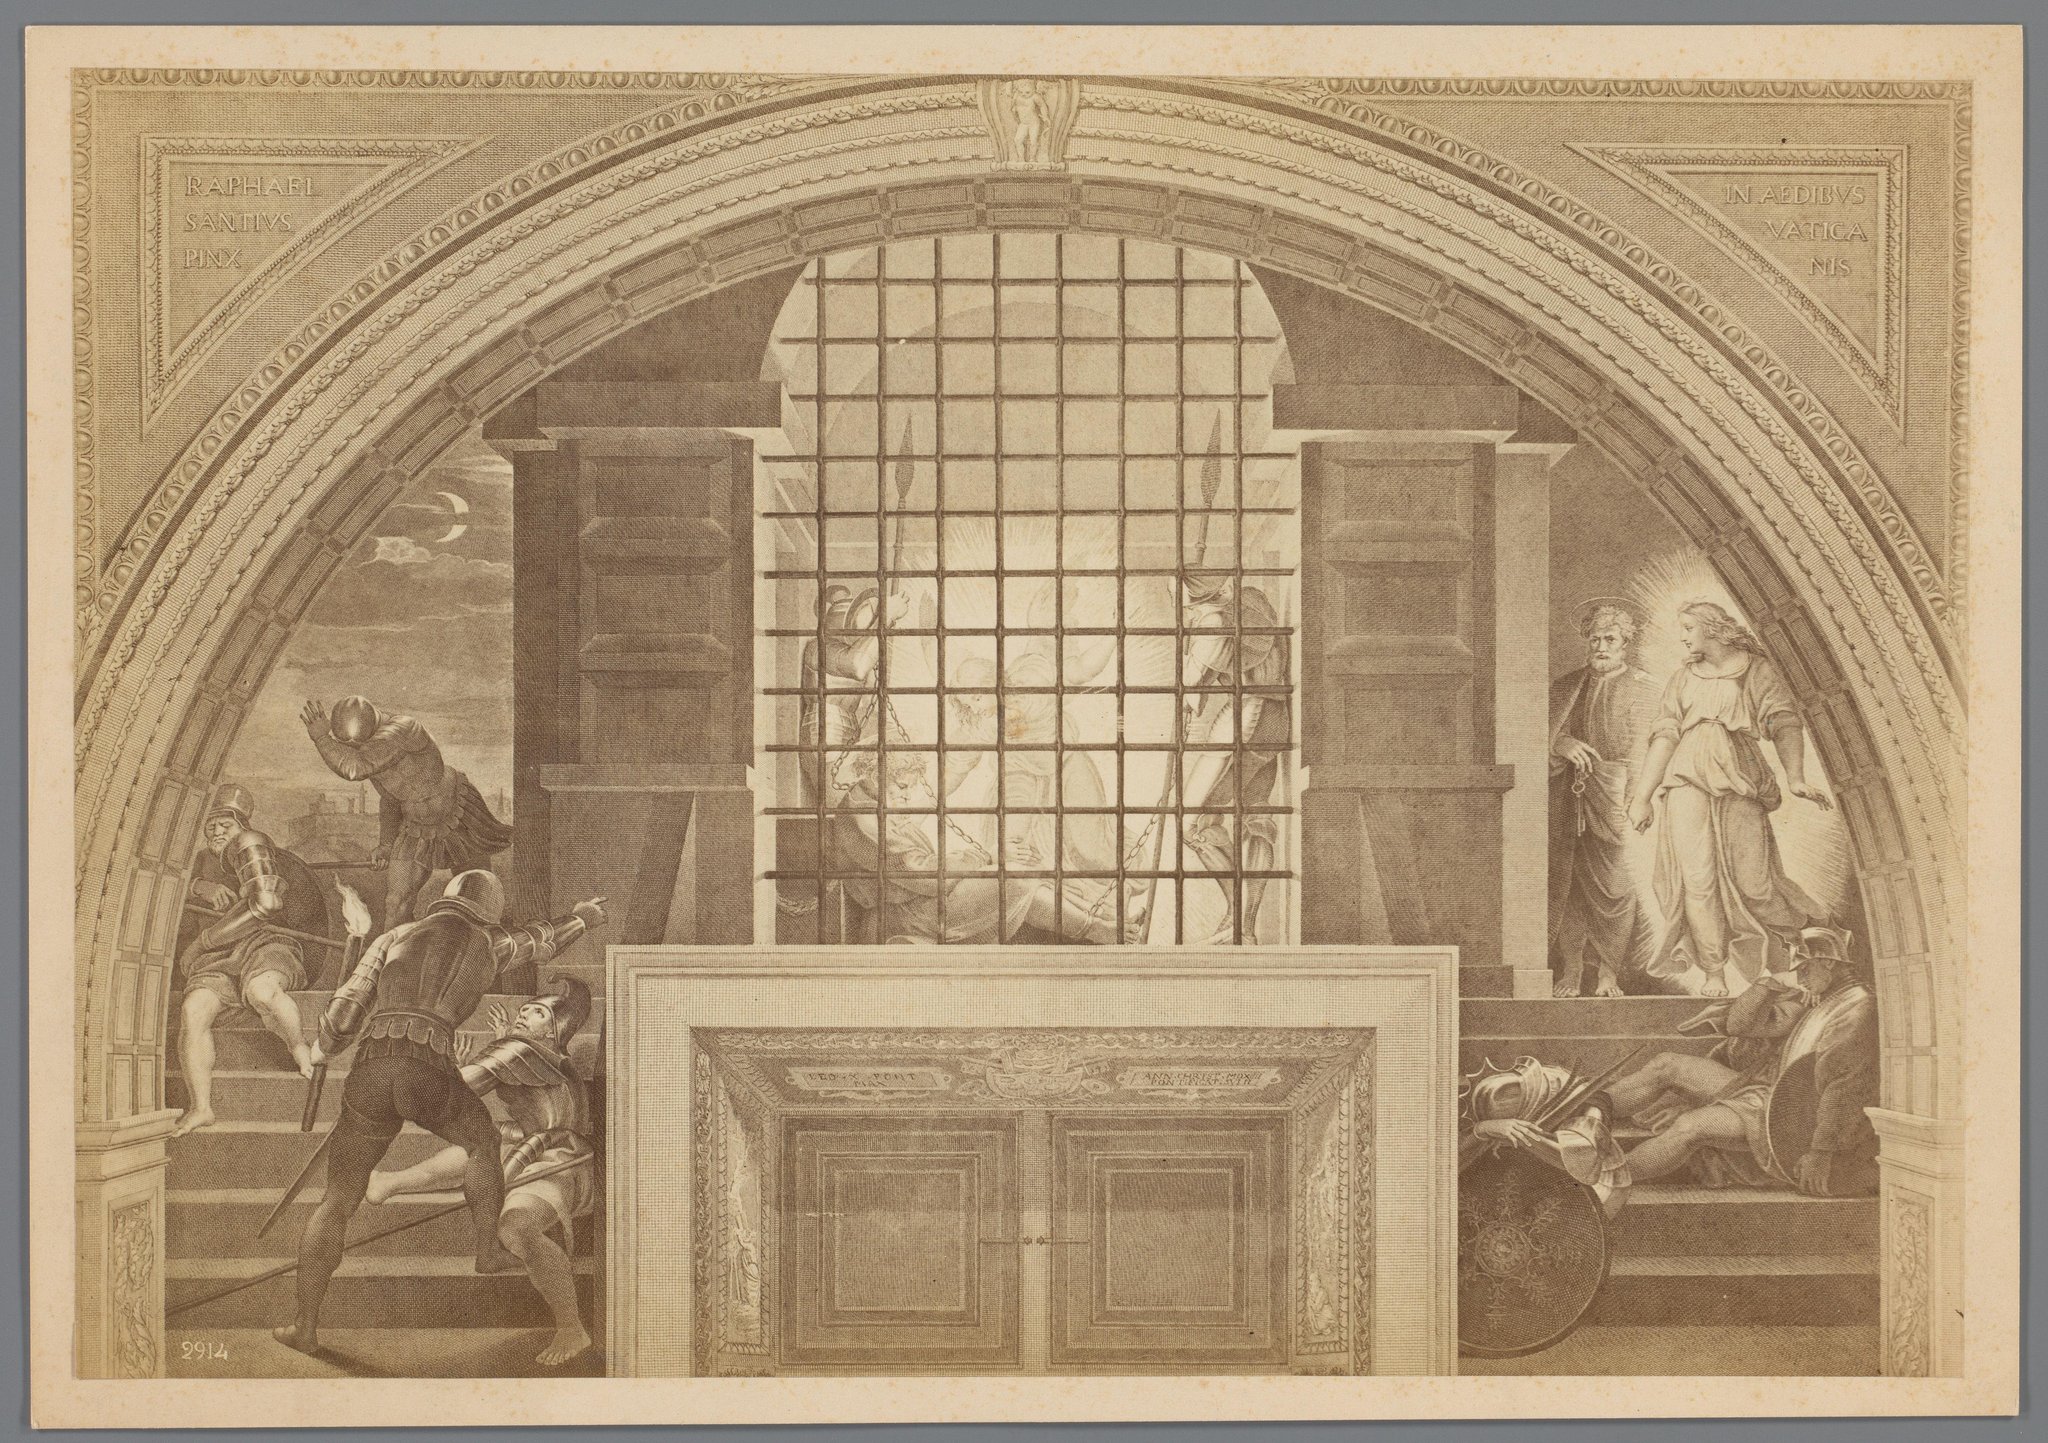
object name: photograph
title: Fotoreproductie van een prent naar het fresco De bevrijding van Petrus door Rafaël in het Apostolisch Paleis, Vaticaanstad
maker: Anonymous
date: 1860-1900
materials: cardboard, paper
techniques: albumen print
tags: an angel appears, summoning peter to wake up ~ peter in prison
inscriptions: number: ‘2914’